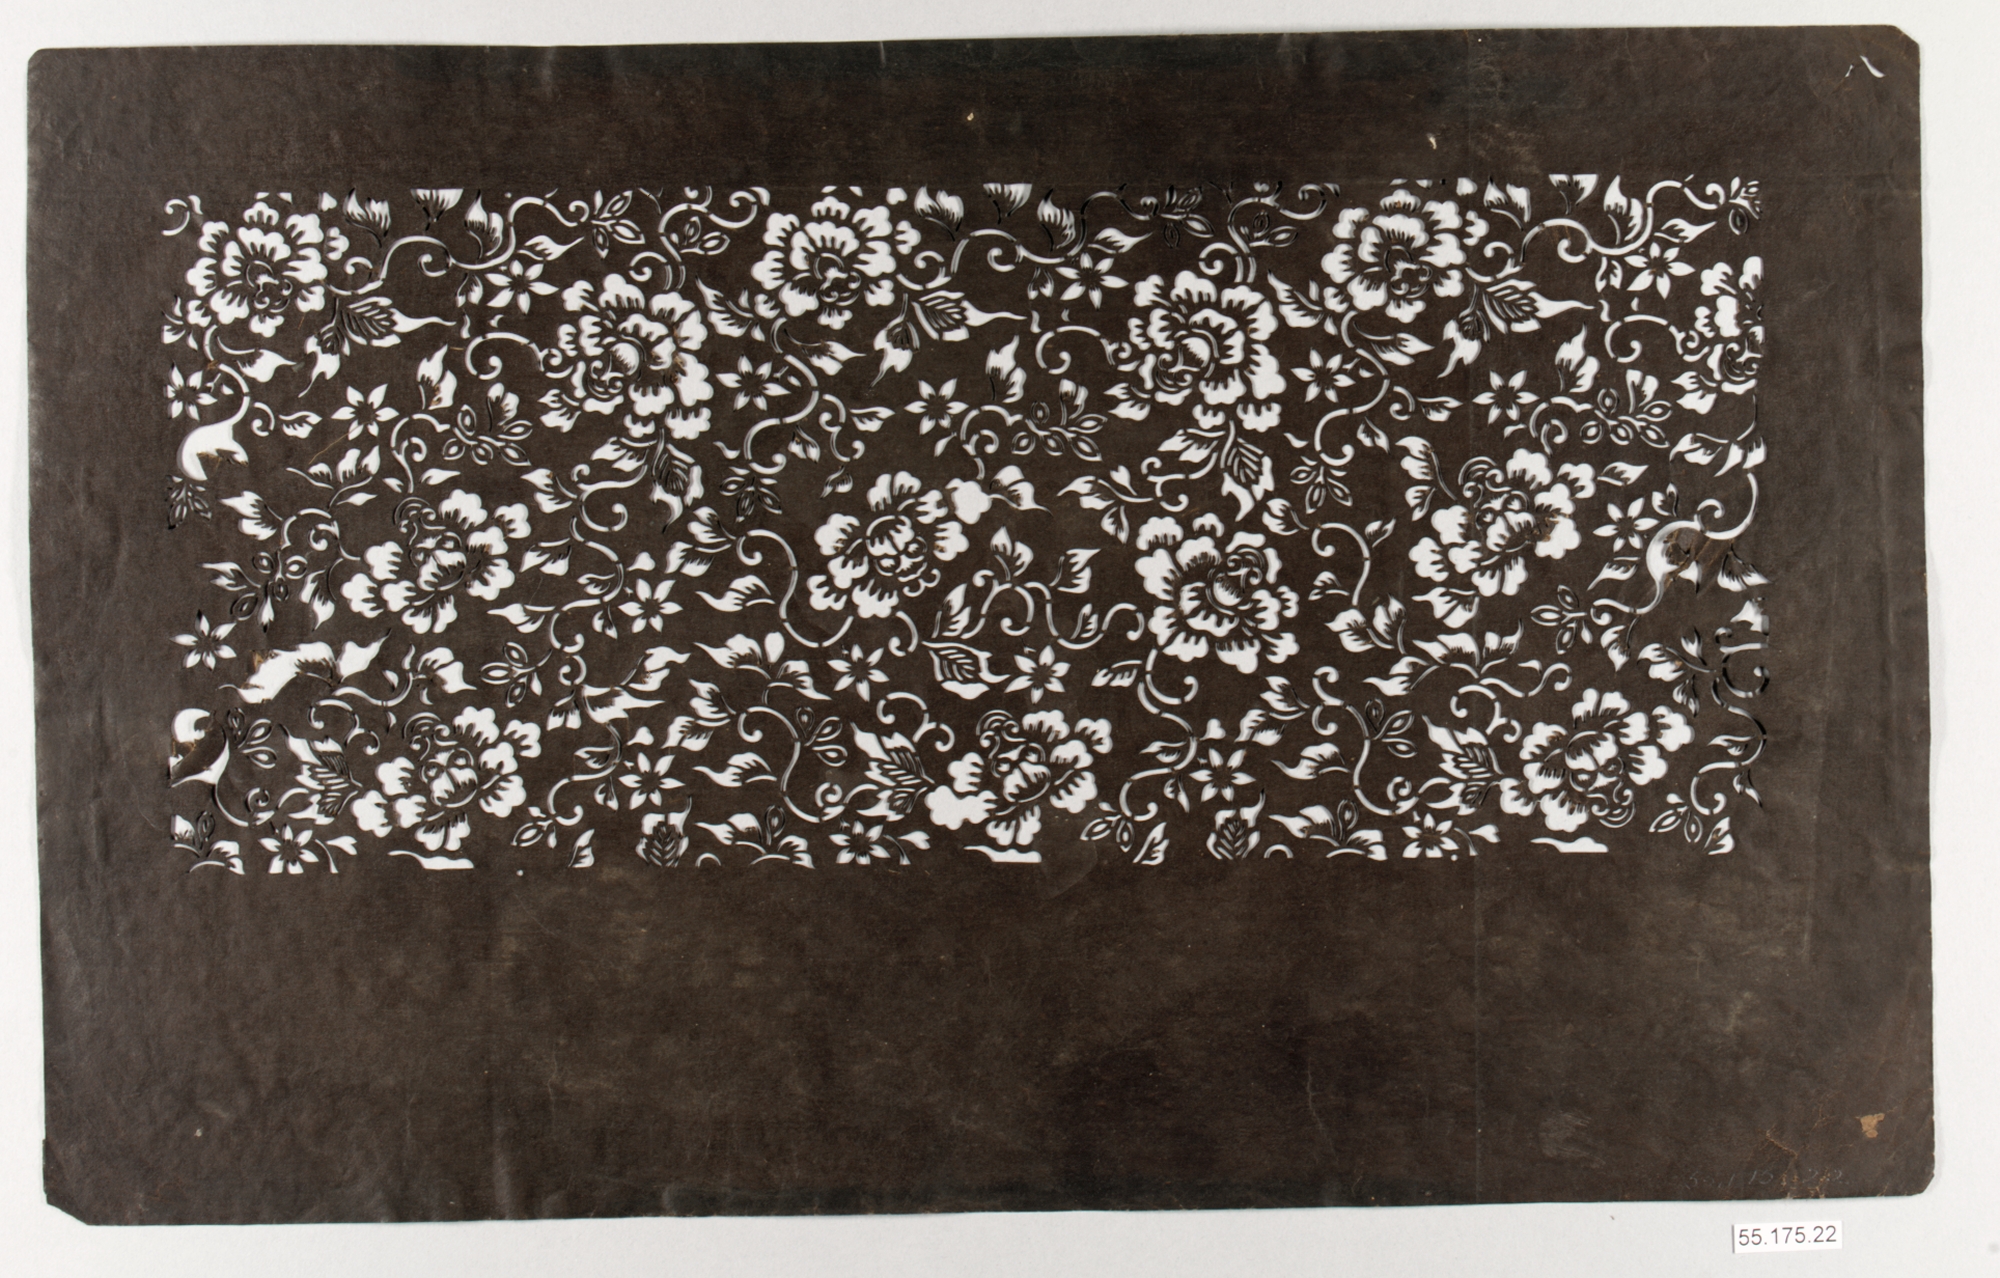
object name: stencil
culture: japanese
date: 1801-1900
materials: paper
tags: flowers